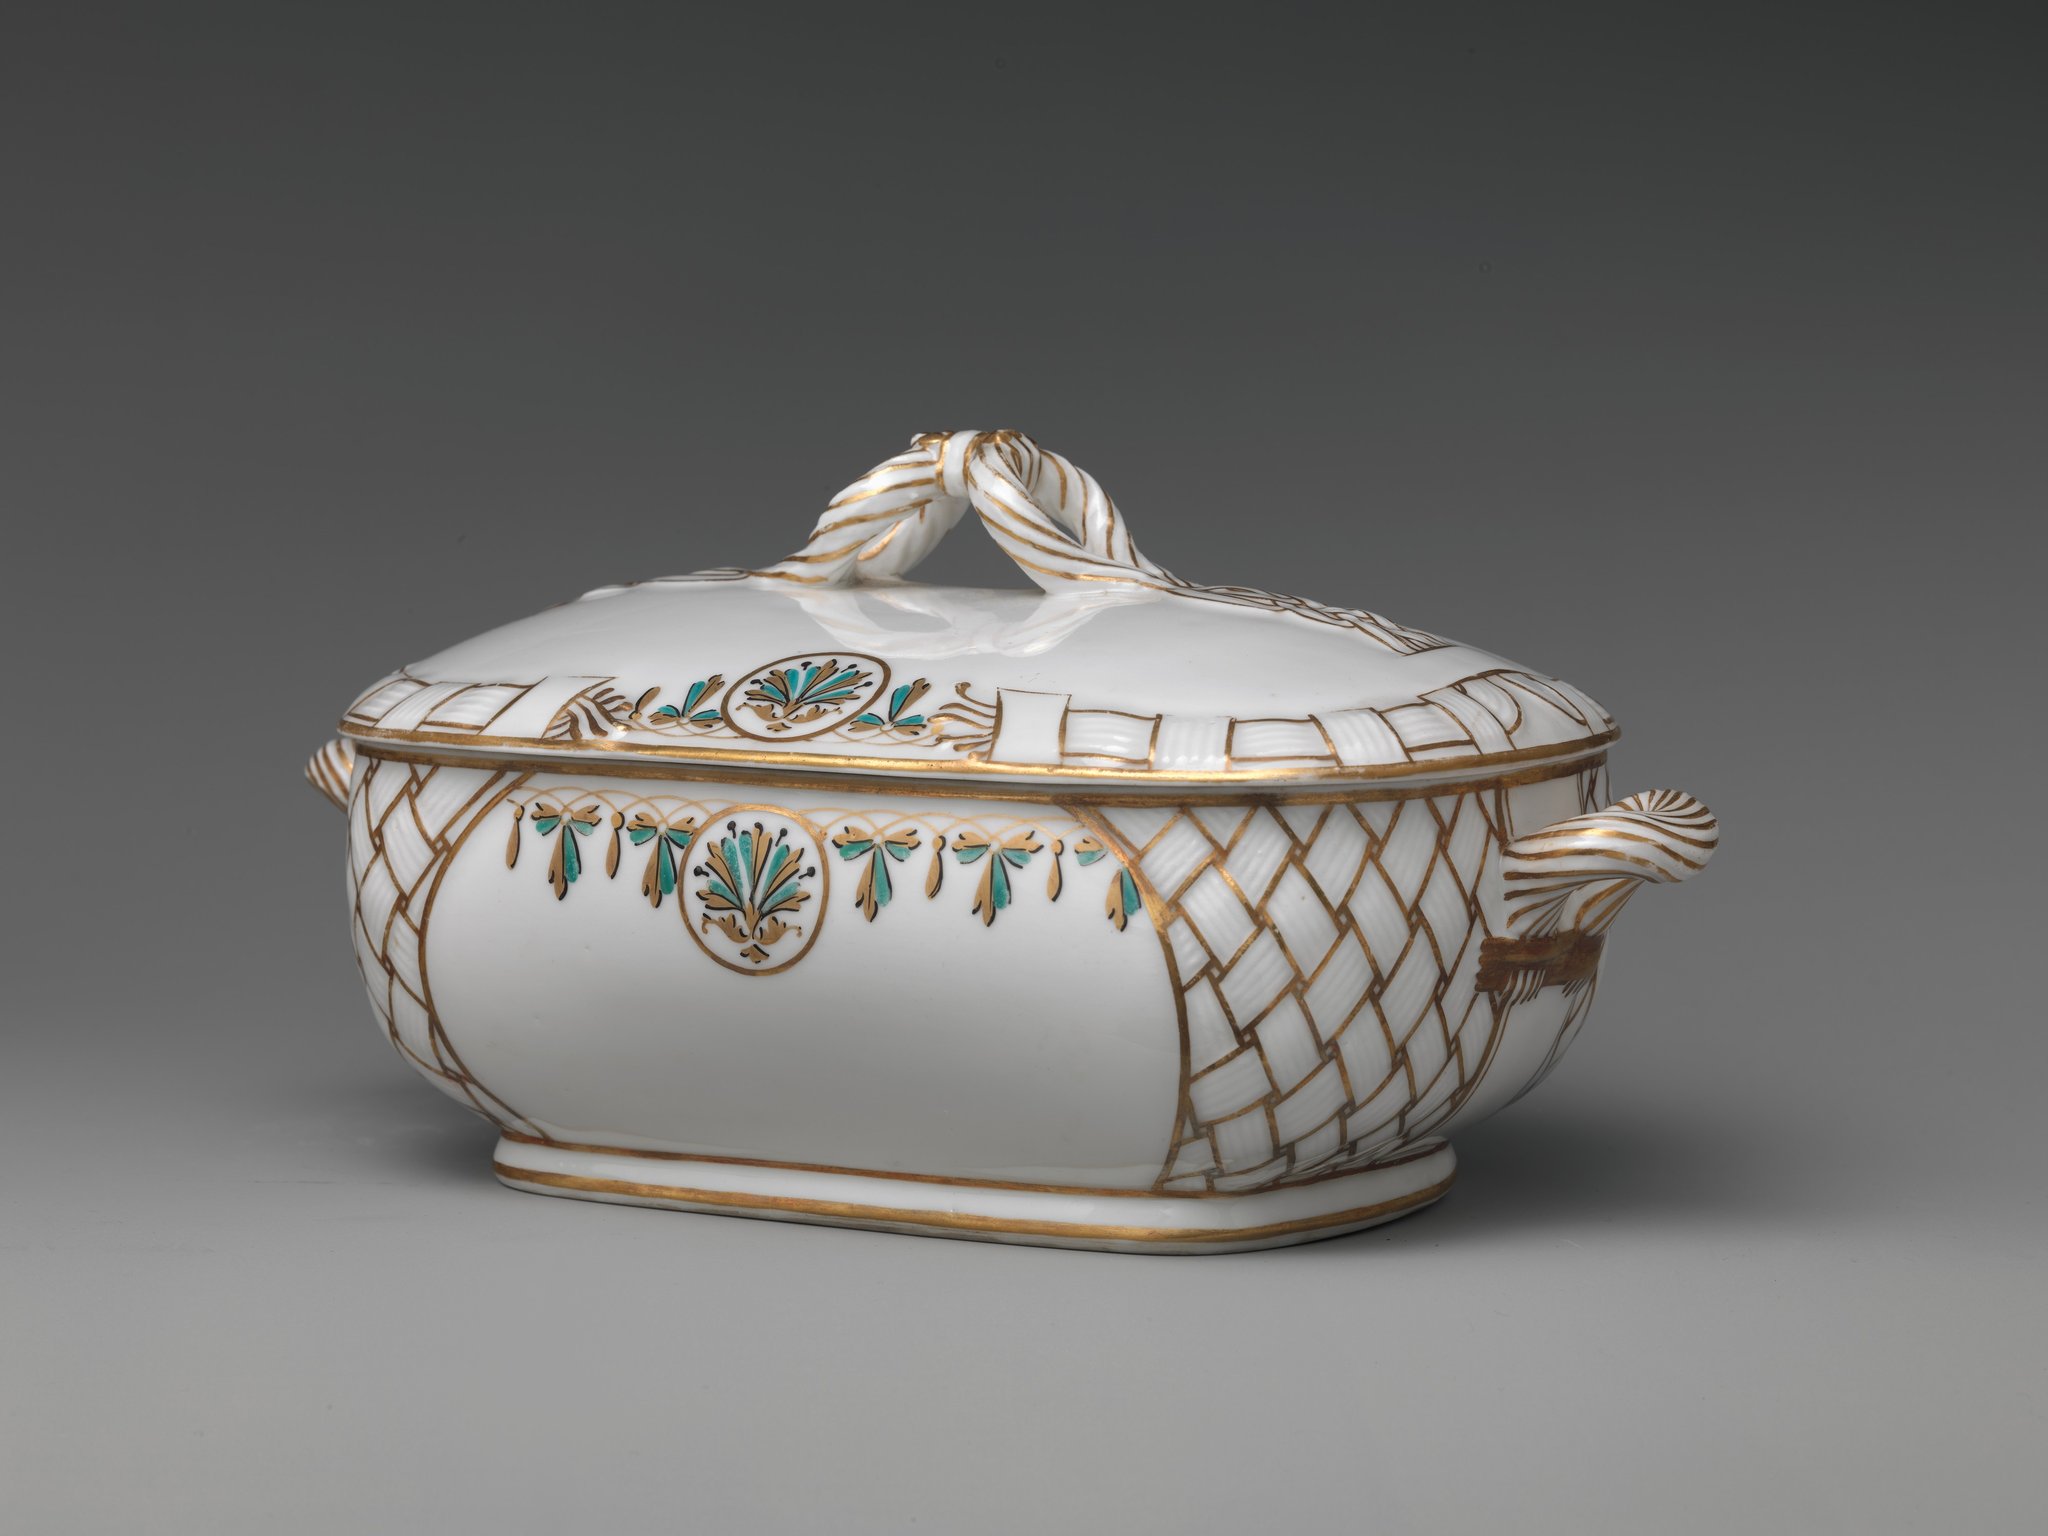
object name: vegetable dish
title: Covered Vegetable Dish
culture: american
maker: union porcelain works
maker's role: maker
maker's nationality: american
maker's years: 1863-1922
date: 1885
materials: porcelain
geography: united states